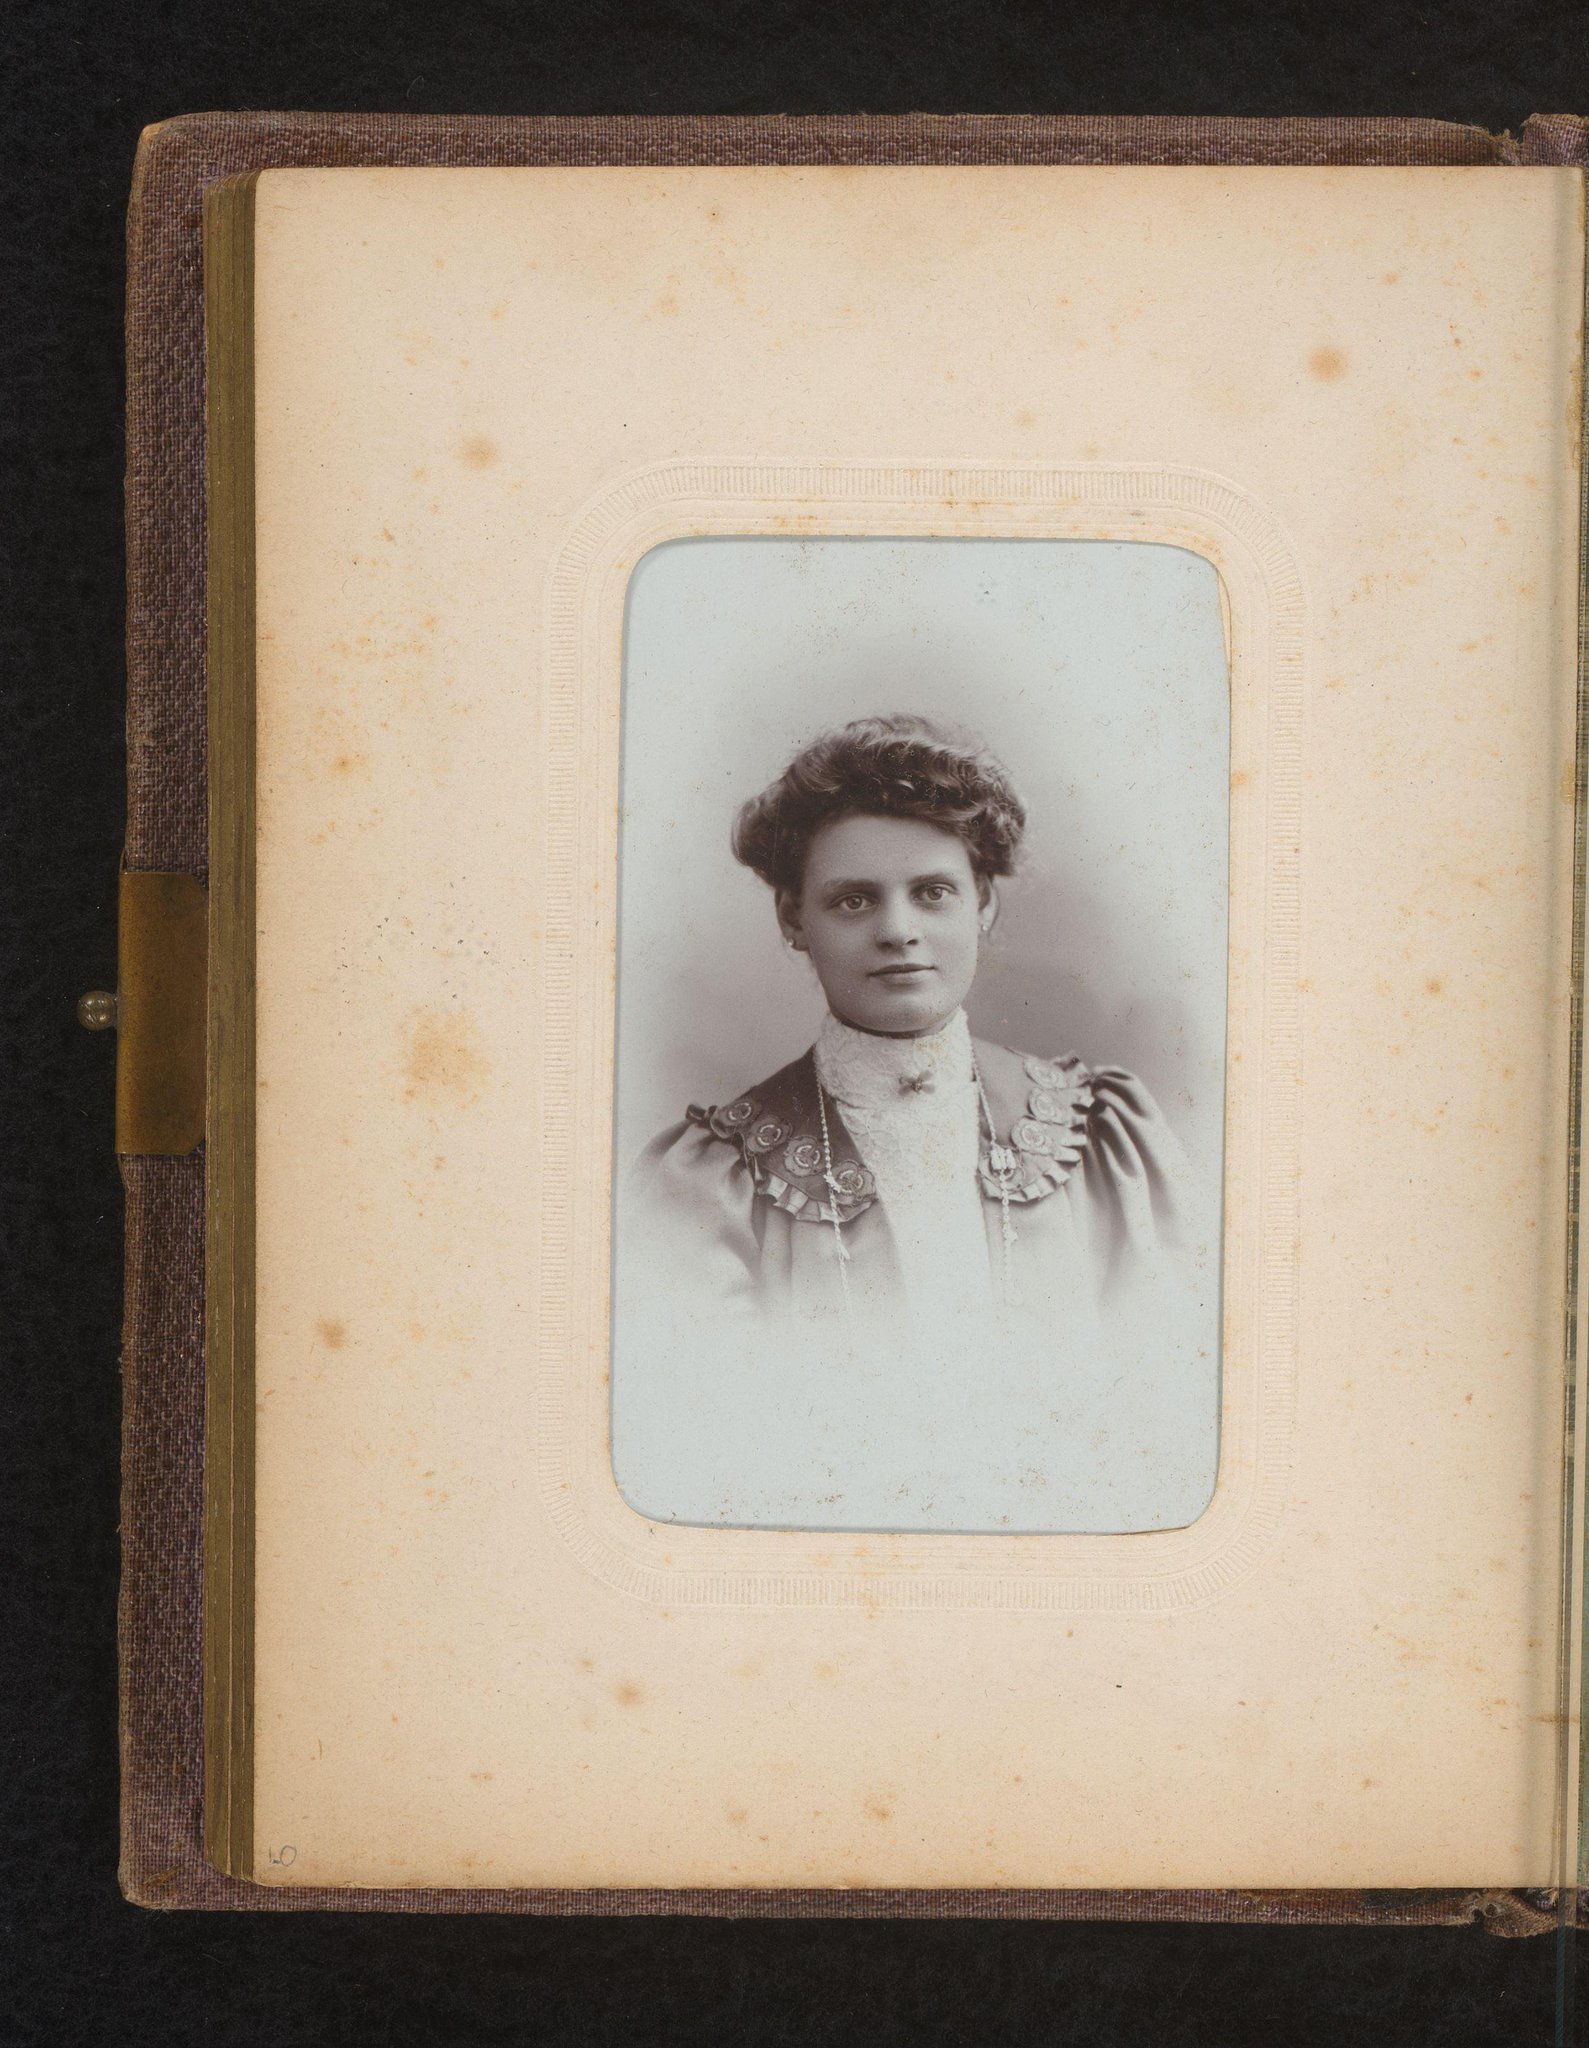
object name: carte de visite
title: Portret van een vrouw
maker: machiel hendricus laddé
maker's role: fotograaf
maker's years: 1866-1932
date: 1892-1906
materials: cardboard, photographic support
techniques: collodion silver print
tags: adult woman, historical persons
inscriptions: inscription: ‘M.H. Laddé Amsterdam/ 57-59 Nieuwendijk’